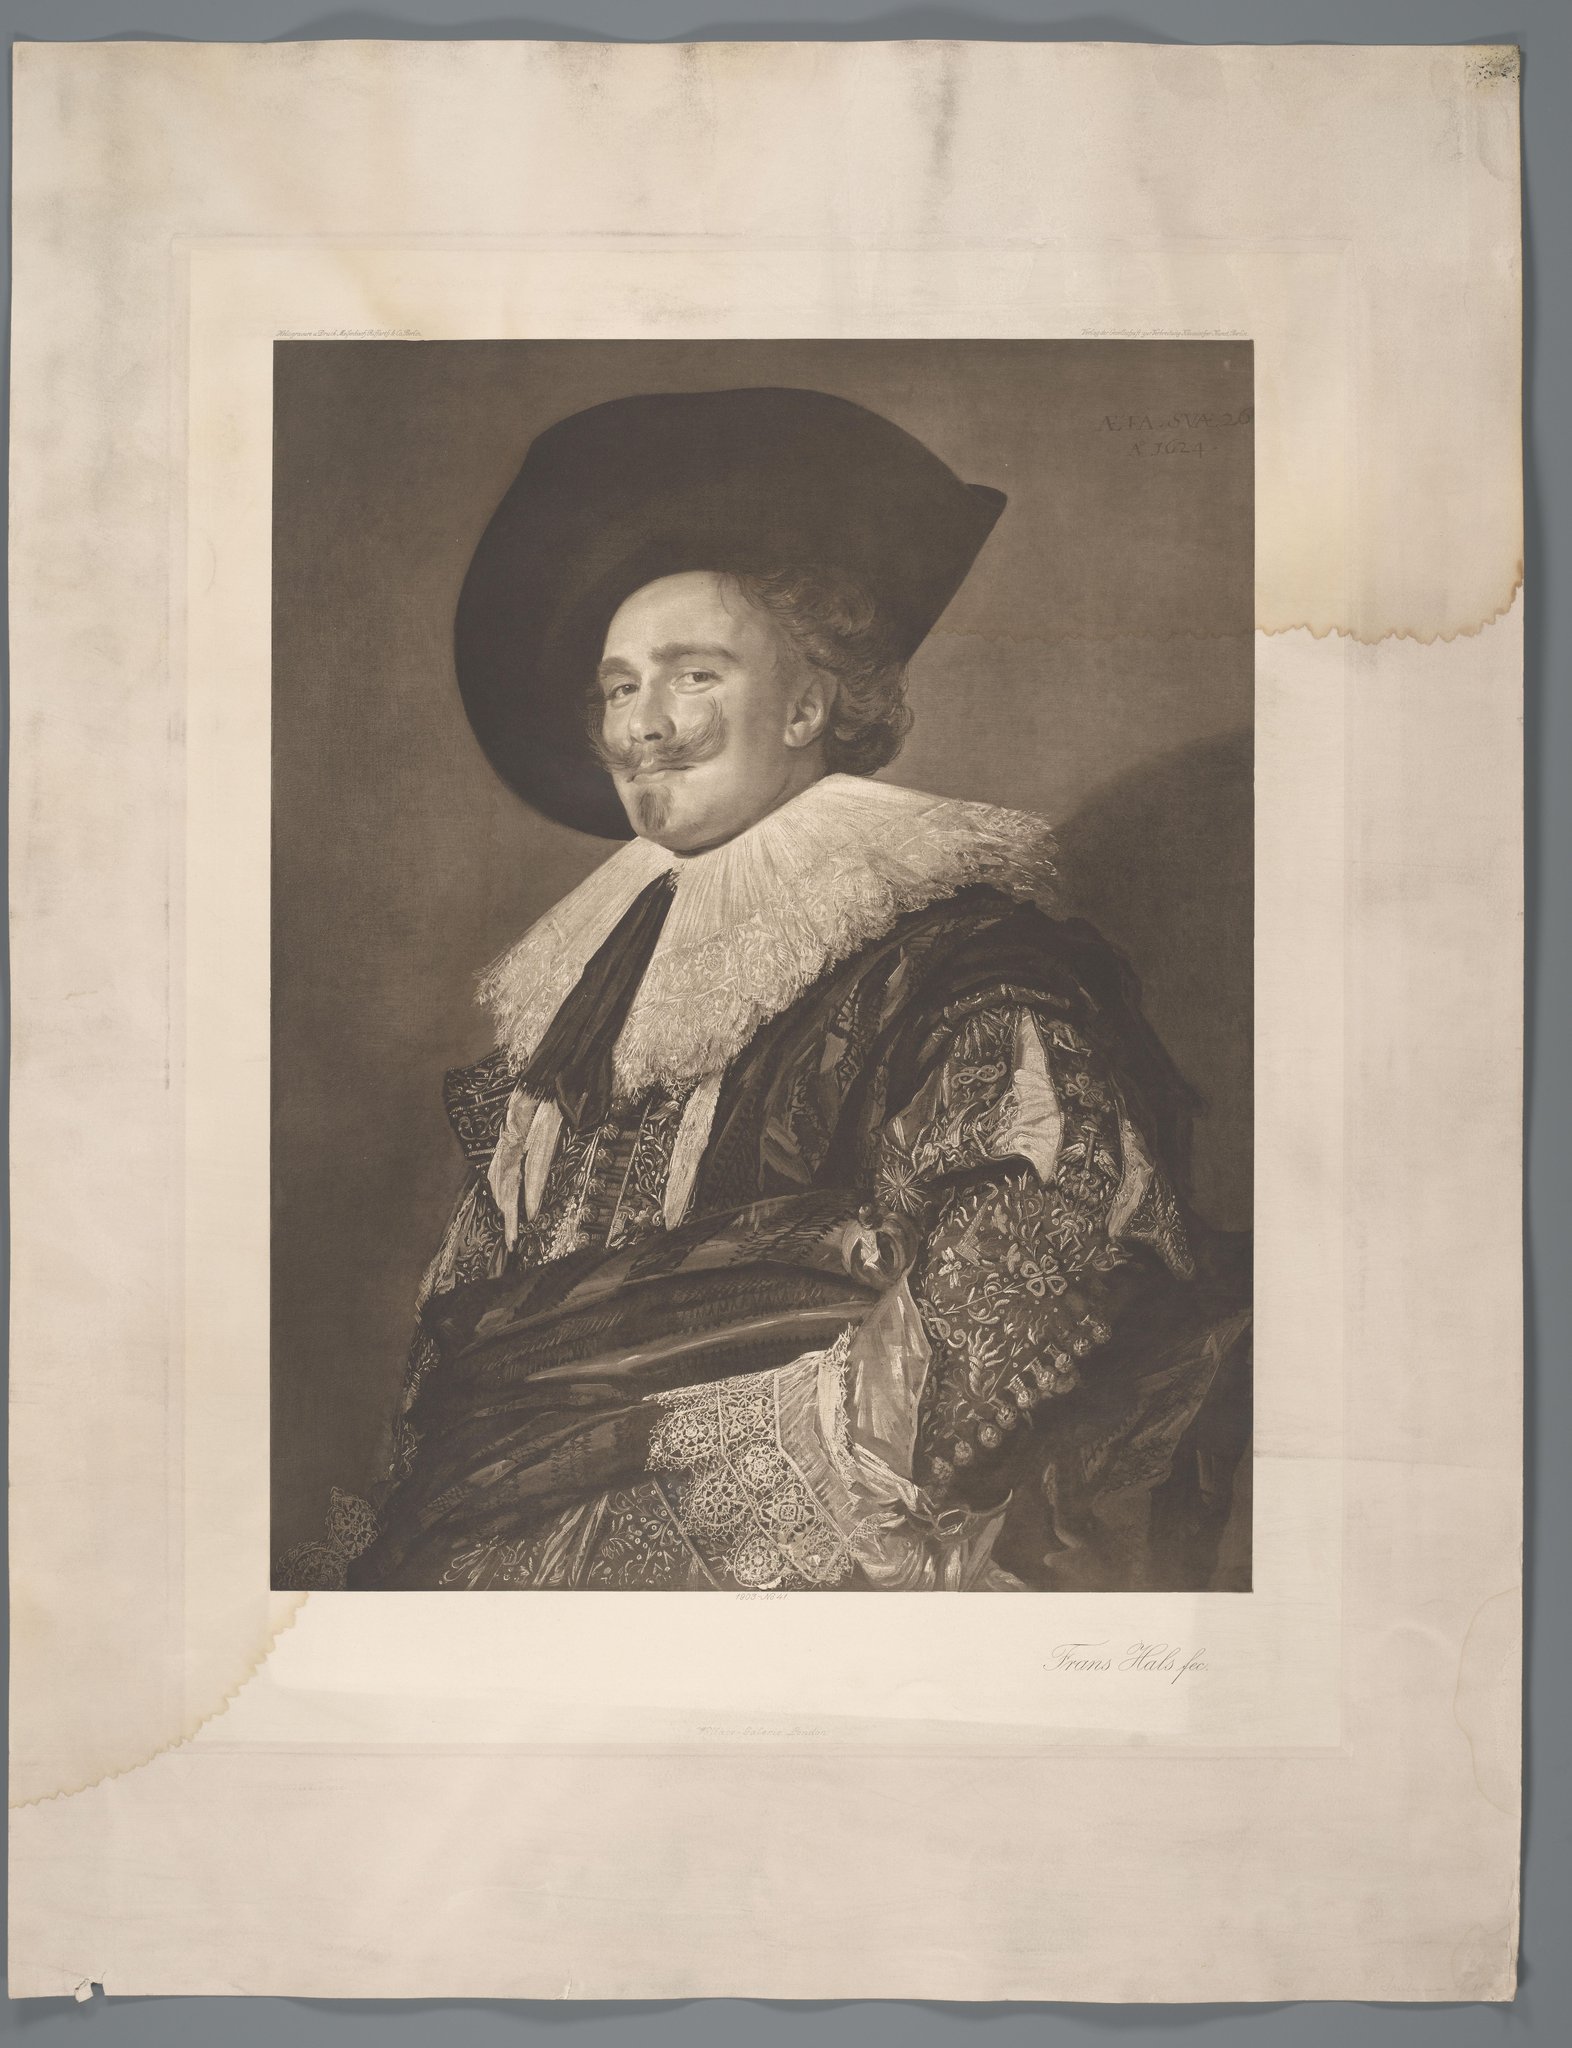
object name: photomechanical print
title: Fotoreproductie van De lachende Cavalier door Frans Hals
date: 1903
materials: cardboard, paper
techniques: photoaquatint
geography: berlin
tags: historical persons, picture, painting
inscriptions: inscription: ‘Frans Hals fec.’, inscription: ‘1903 - No.41./ Wallace-Galerie. London’, inscription: ‘'04. 176’, inscription: ‘Verlag der Gesellschaft zur Verbreitung Klassischer Kunst. Berlin.’, inscription, gestempeld: ‘R: MVS.’, inscription: ‘Heliogravure u. Druck Meisenbach Riffarth & Co, Berlin’